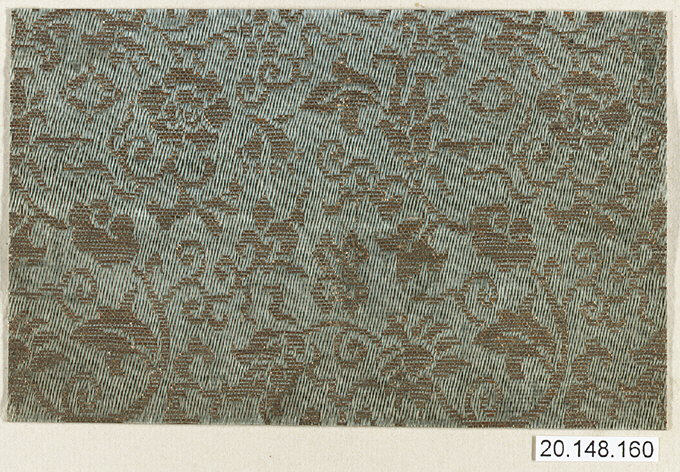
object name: piece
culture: japanese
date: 1701-1800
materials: silk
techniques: compound weave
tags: flowers